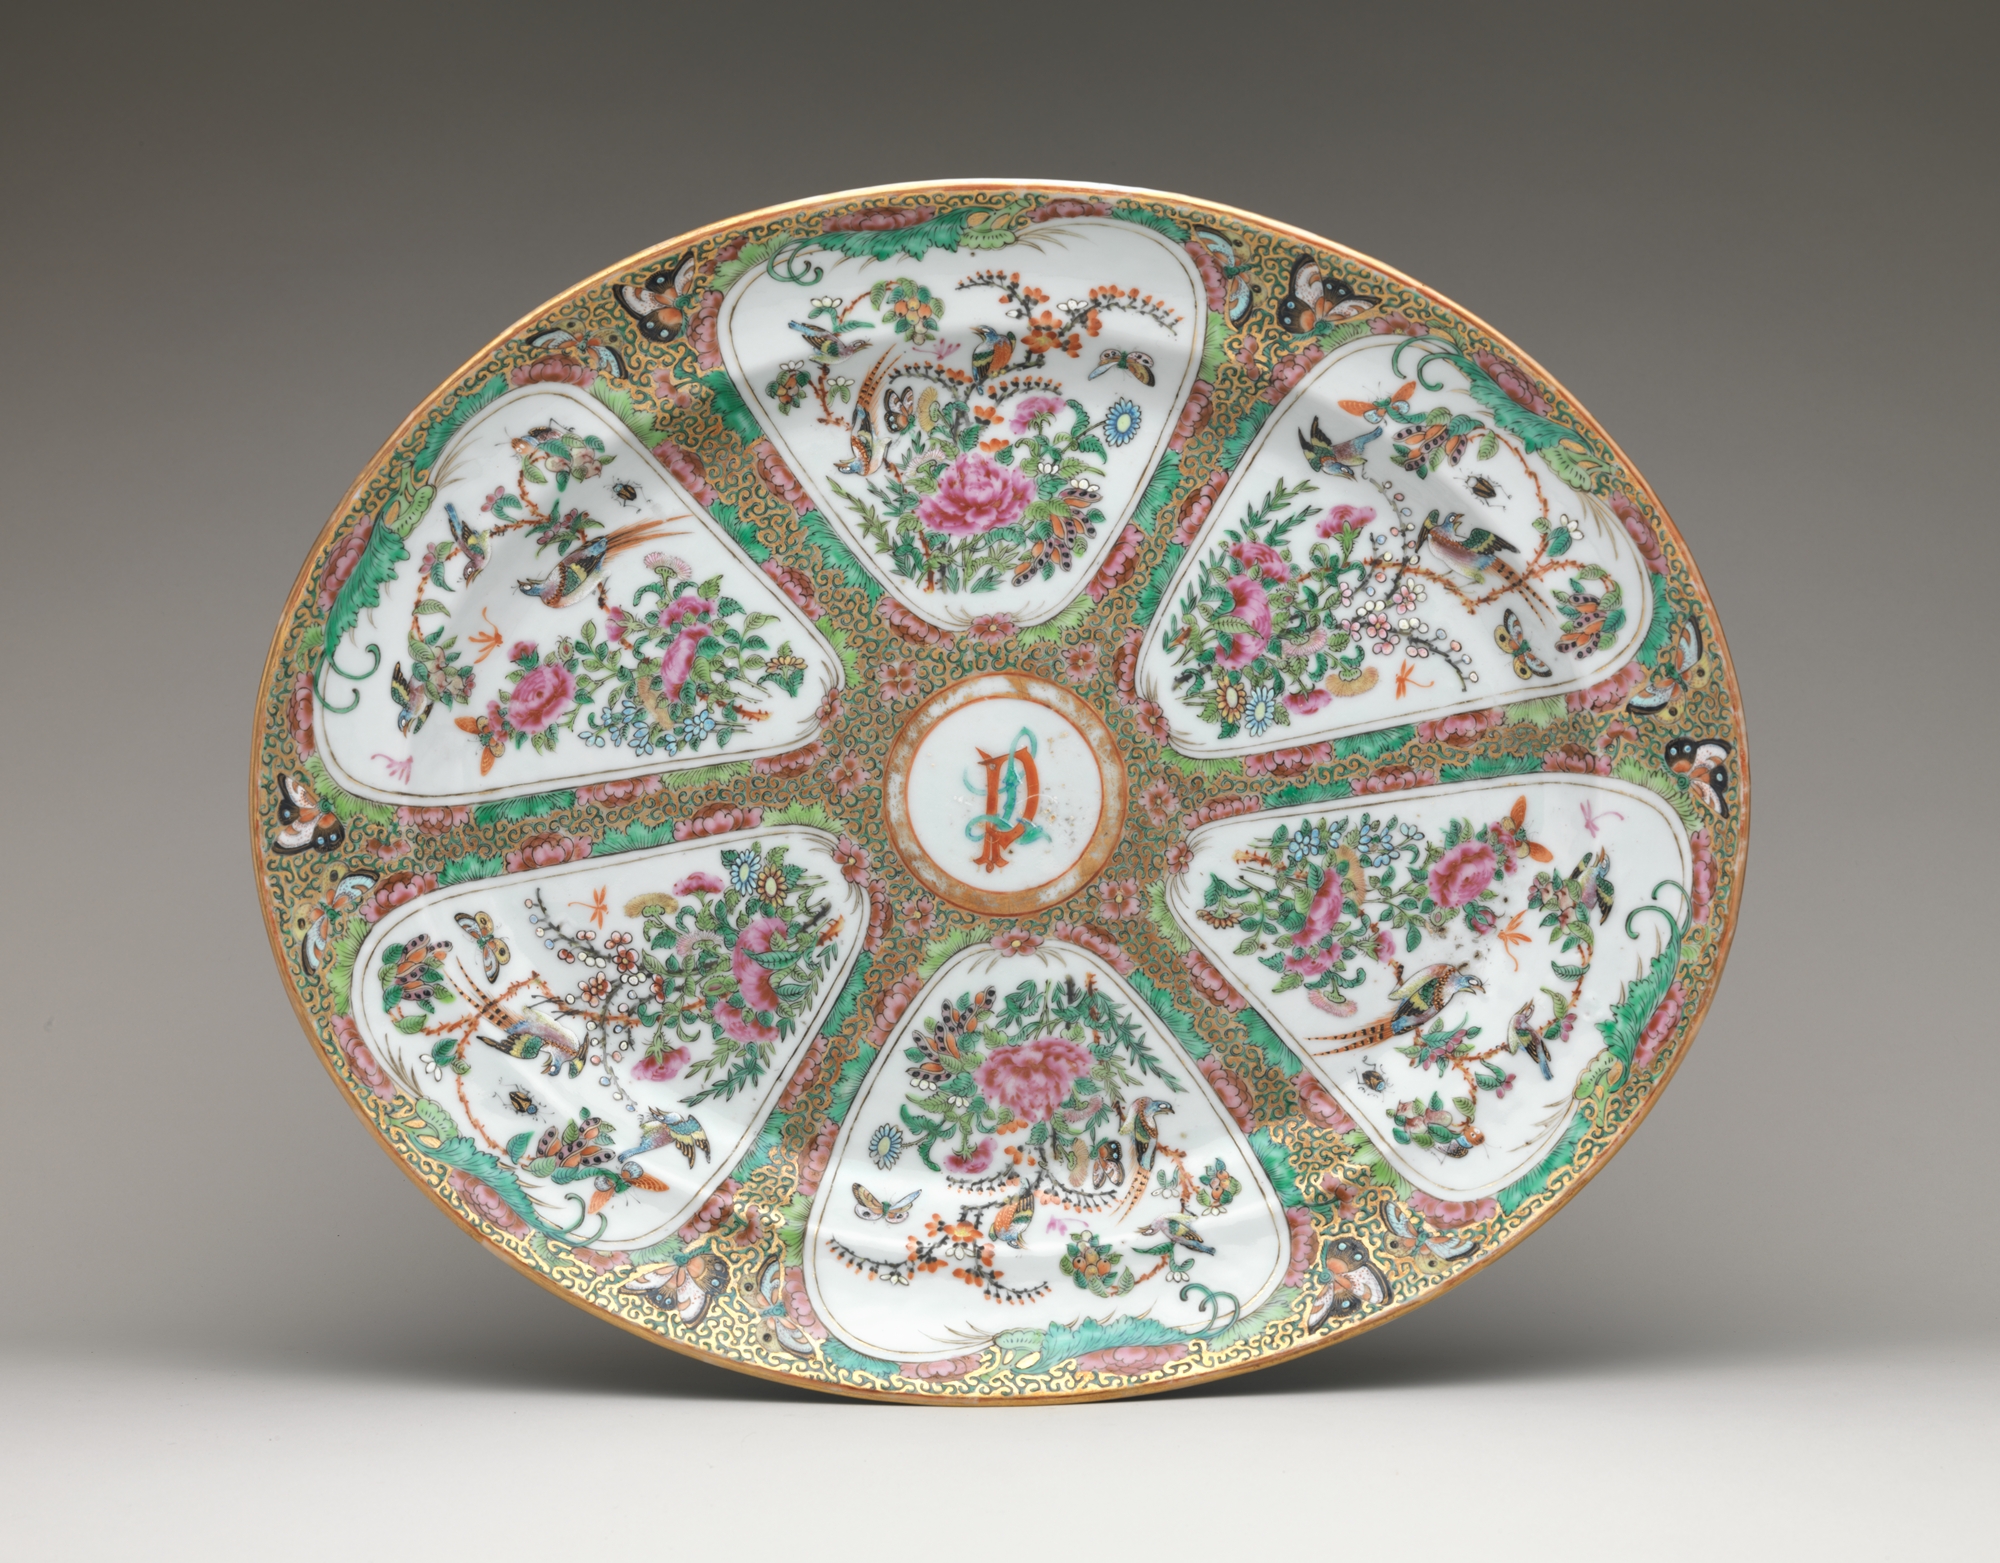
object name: platter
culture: chinese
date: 1860-1866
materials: porcelain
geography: china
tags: birds,butterflies,flowers